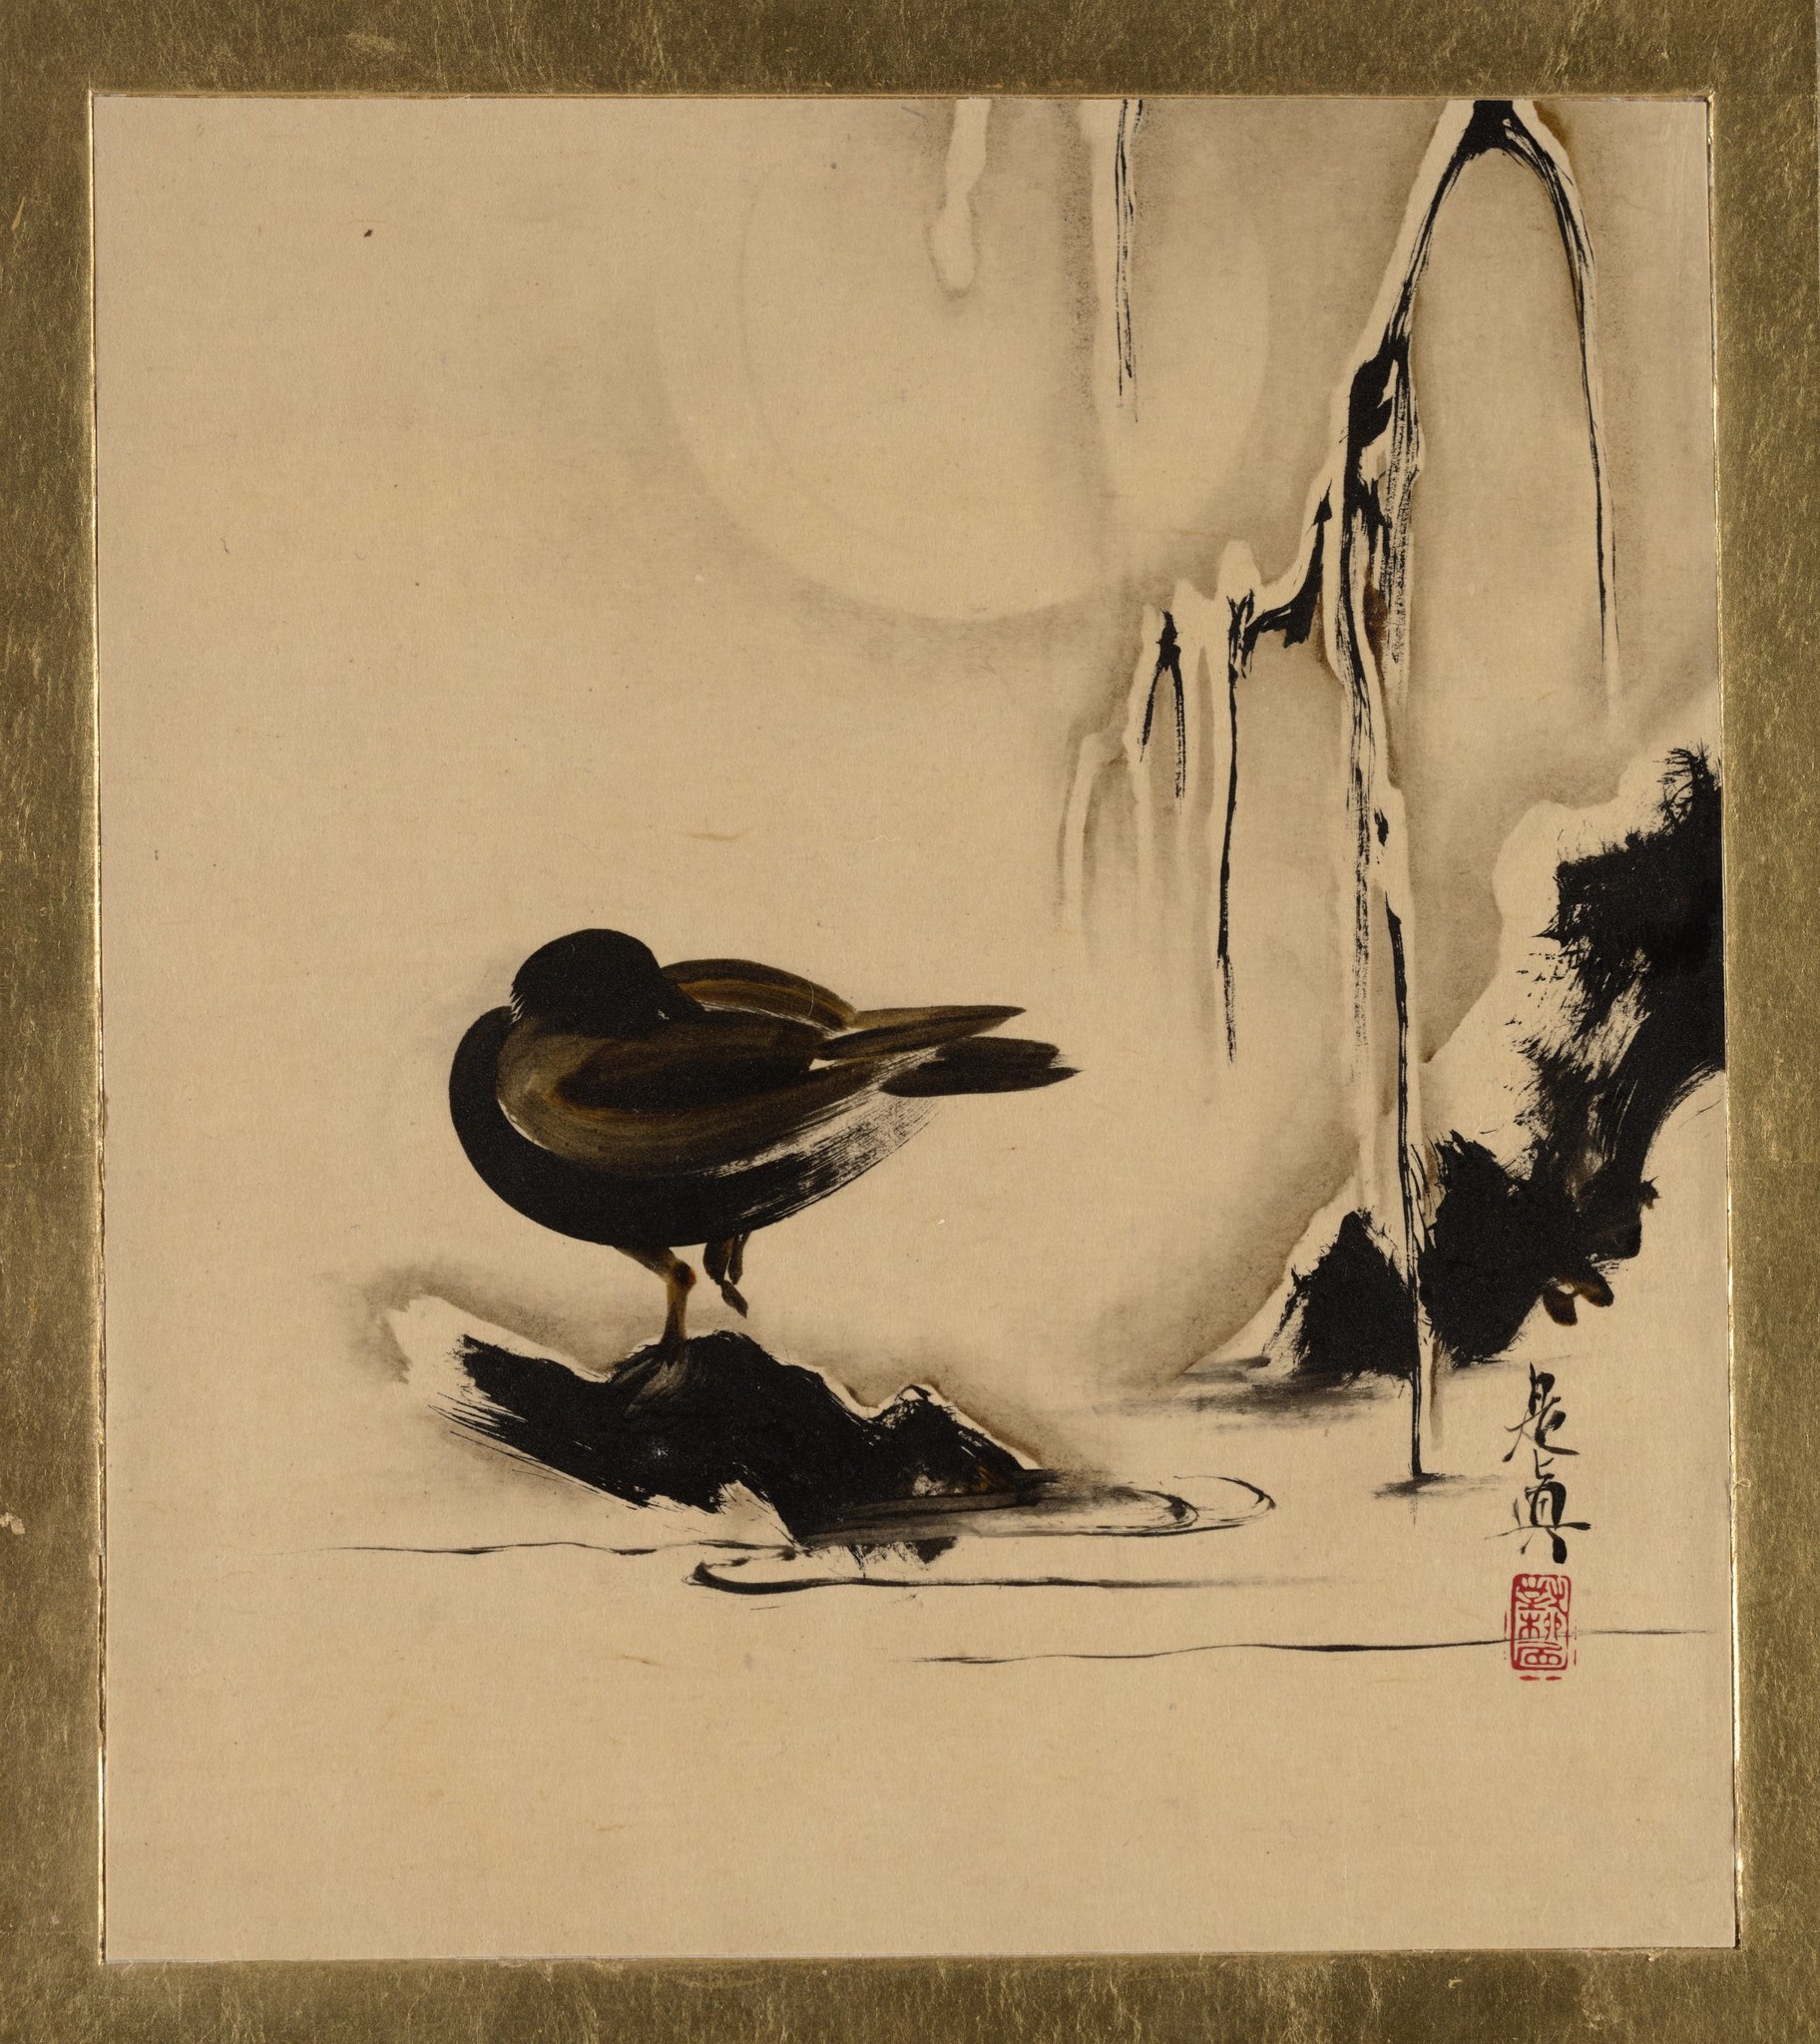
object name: album leaf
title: Lacquer Paintings of Various Subjects: Bird and Willow in Snow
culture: japanese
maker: shibata zeshin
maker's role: artist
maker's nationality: japanese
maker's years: 1807-1891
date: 1882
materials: ink, lacquer, paper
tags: birds,snow